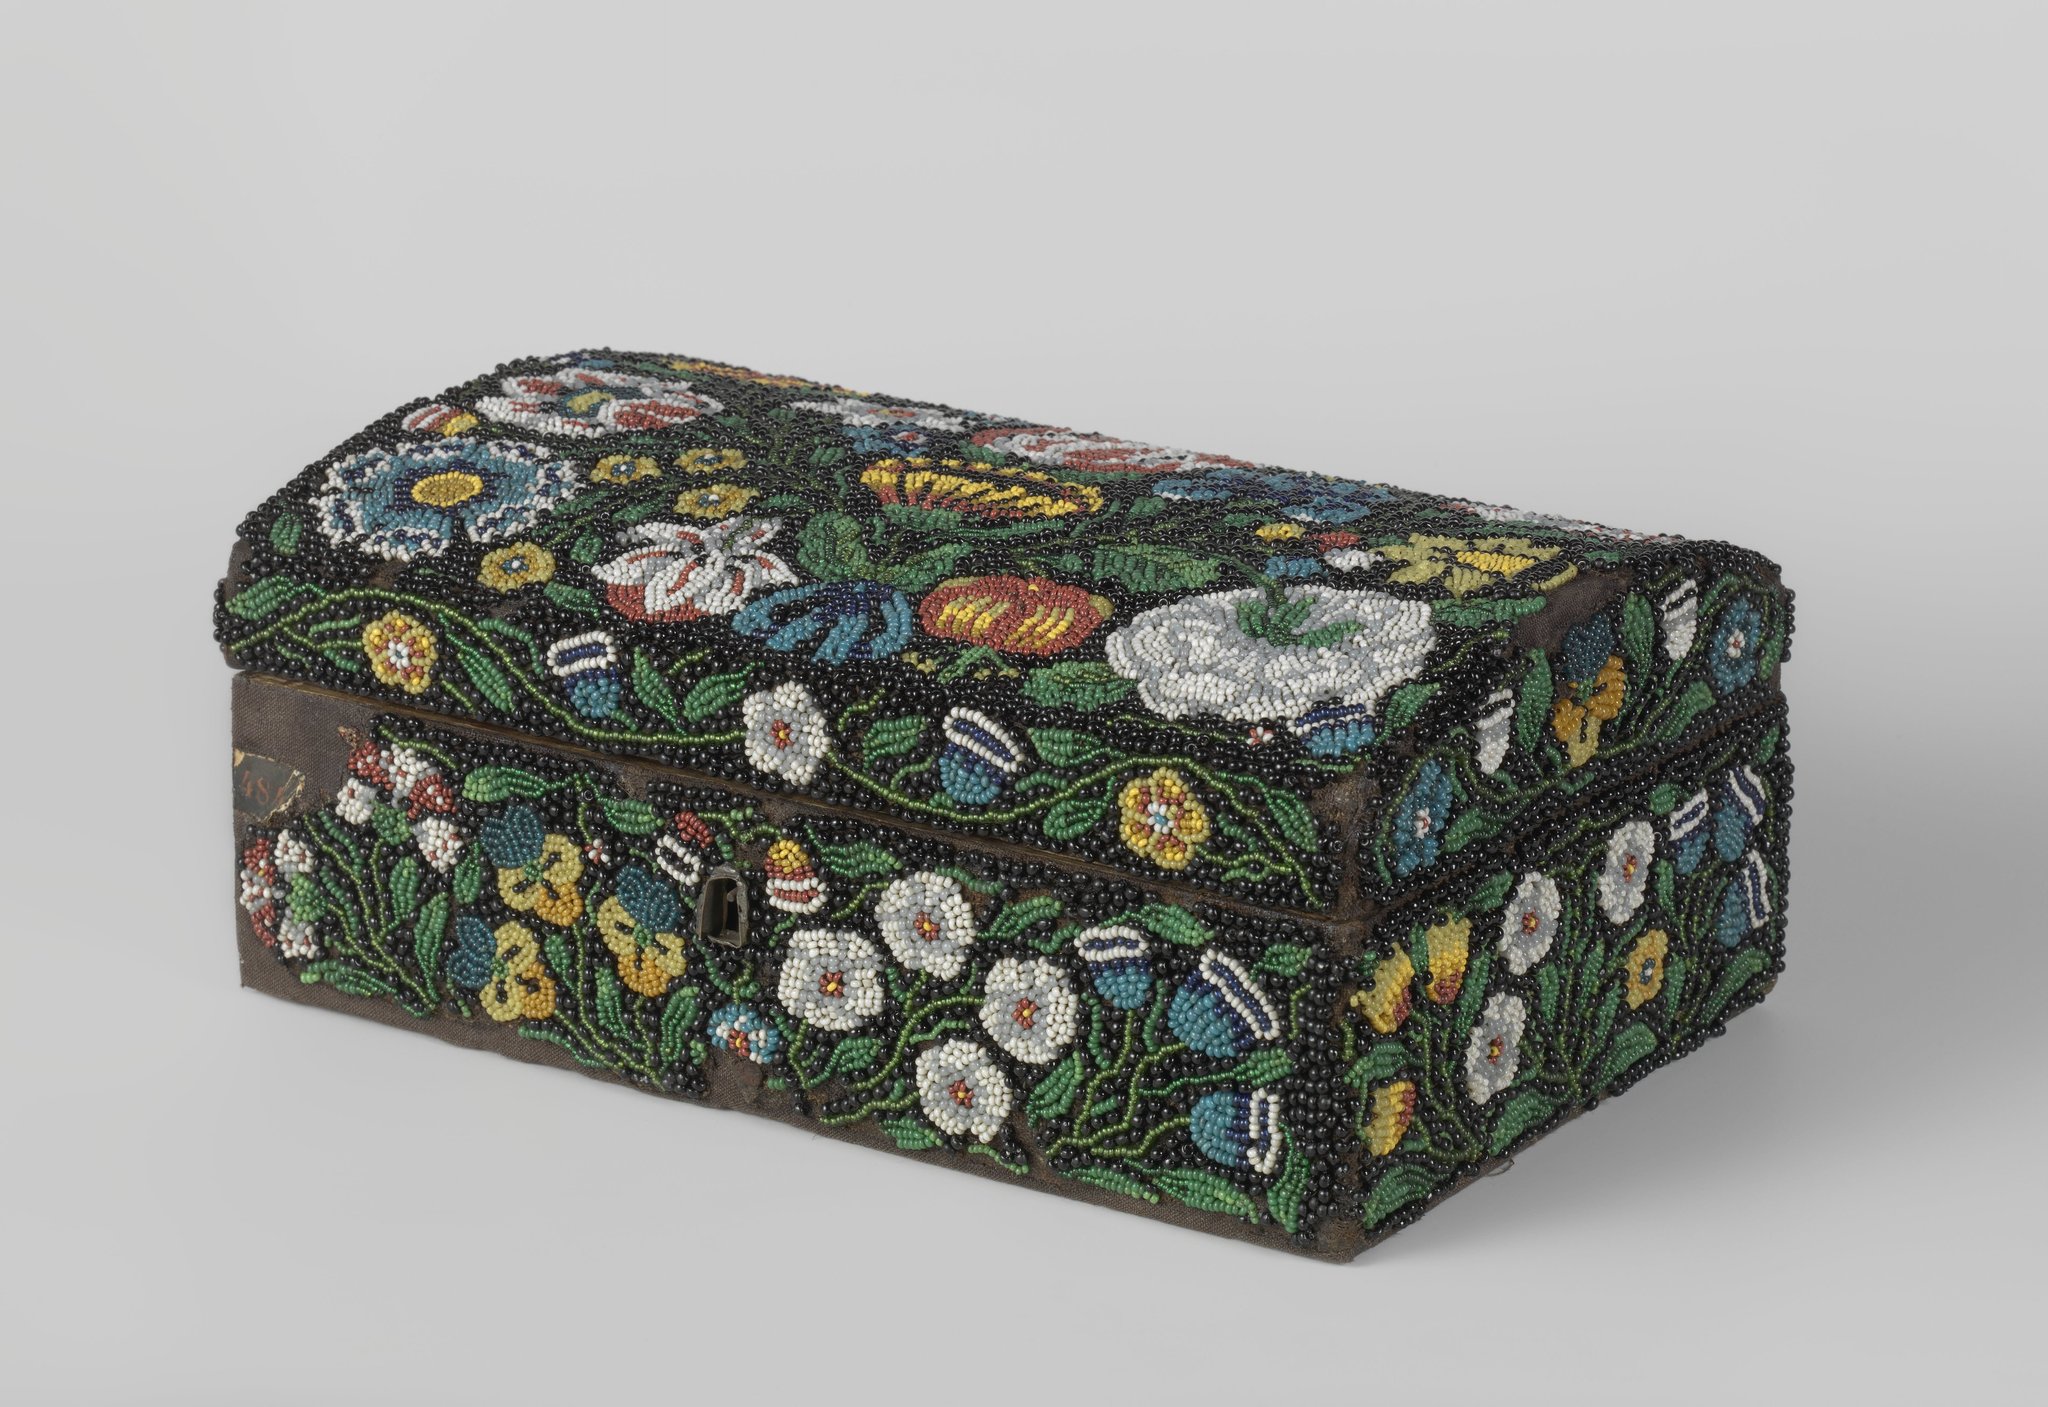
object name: chest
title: Casket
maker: Anonymous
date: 1700-1800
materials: glass, wood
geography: netherlands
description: Vergelijk: P. Macquoid en R. Edwards, The dictionary of English Furniture, New York 1934, fig. 28 (coll. Mr. Percival Griffiths, ca. 1700).